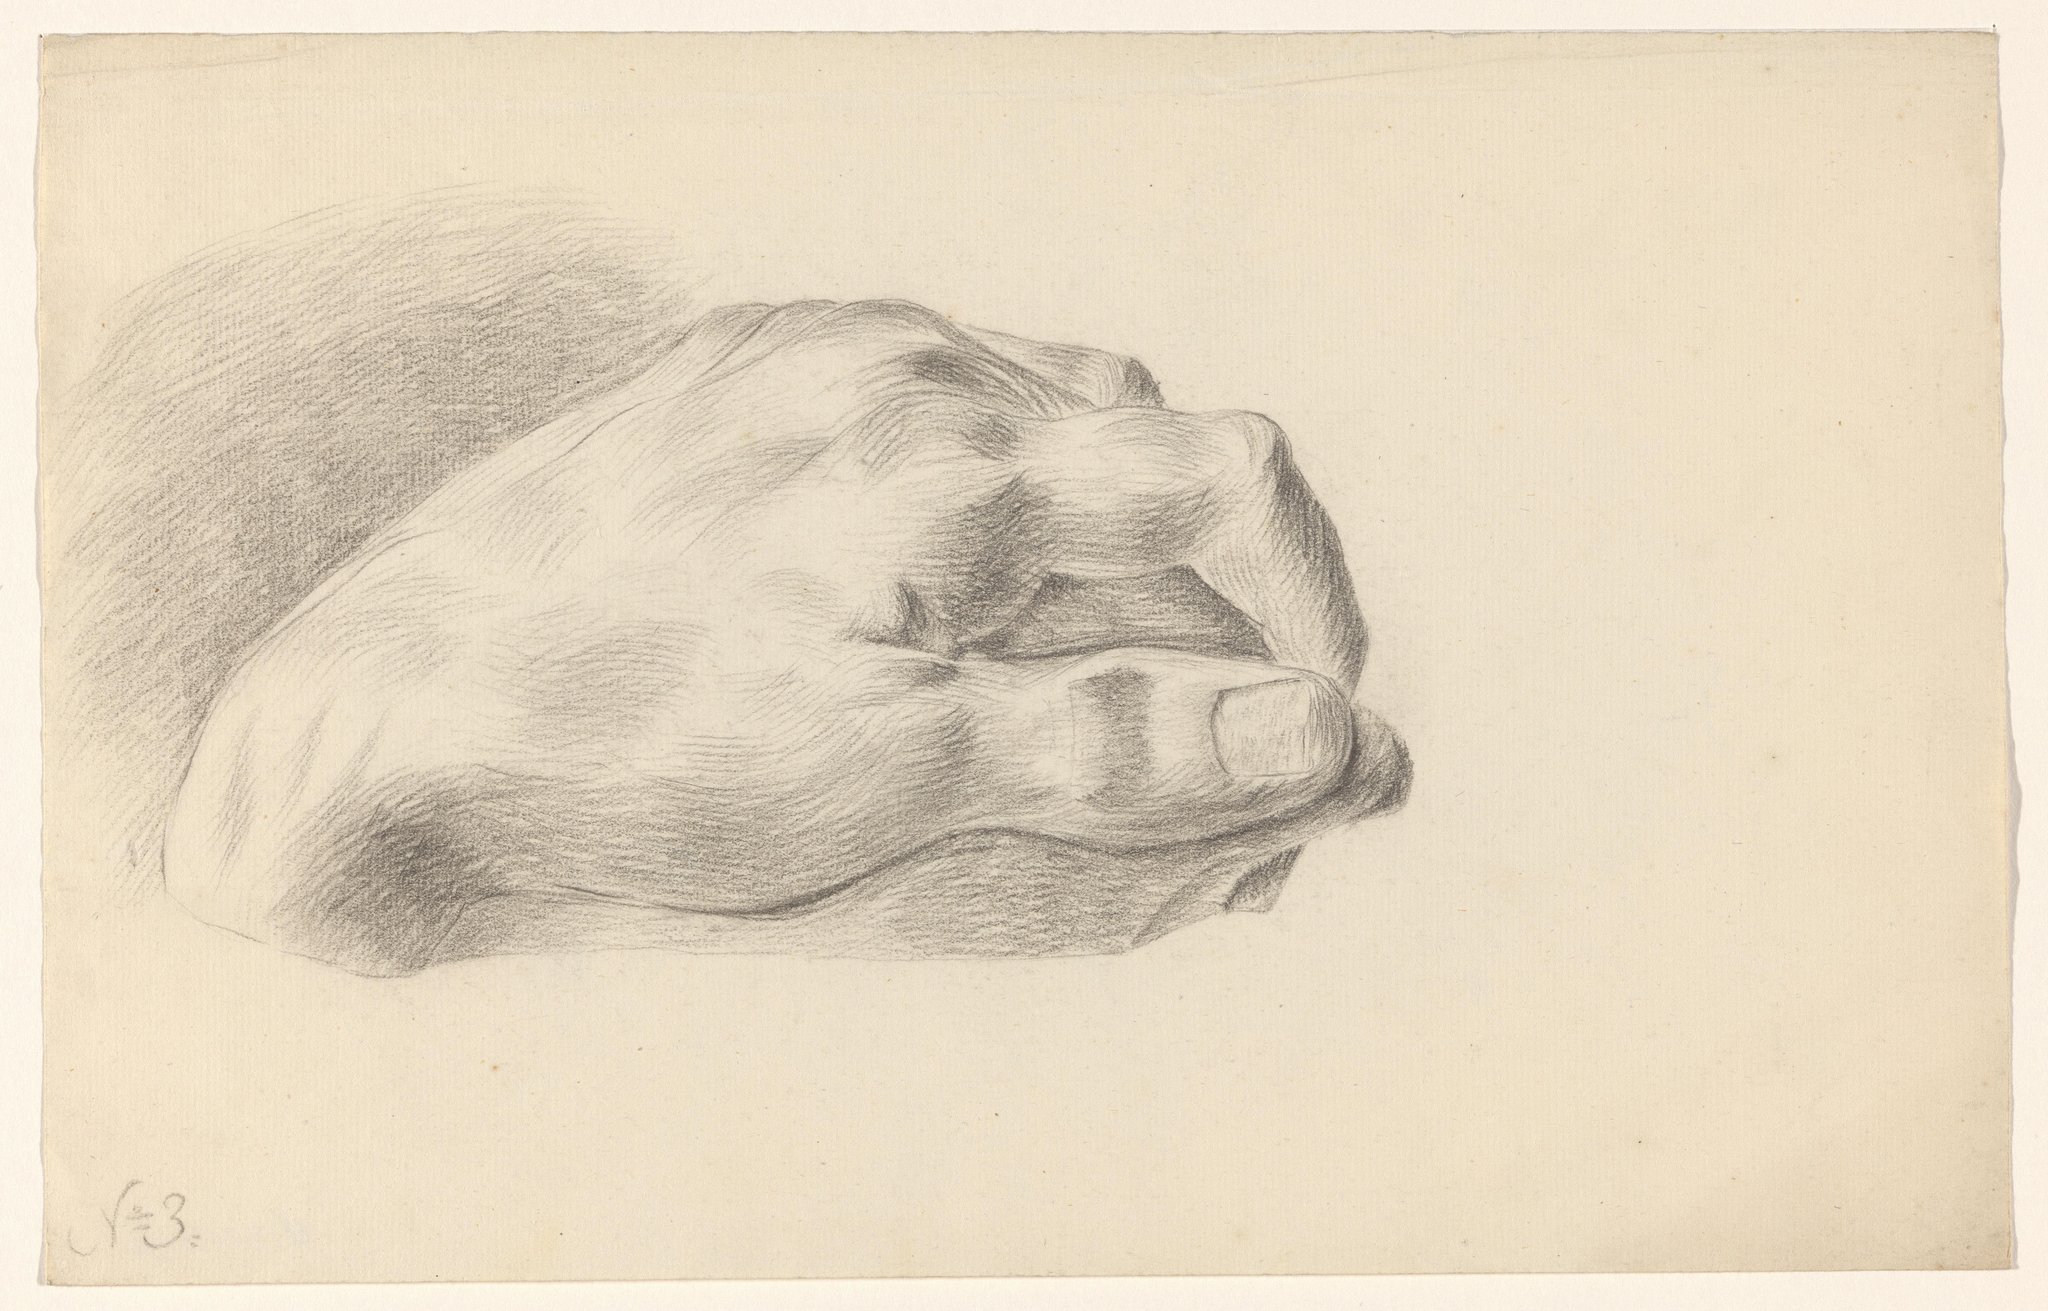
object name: drawing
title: Studie van een hand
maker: Anonymous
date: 1830-1880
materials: chalk, paper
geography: netherlands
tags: postures and gestures of arms and hands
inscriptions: inscription: ‘No 3’